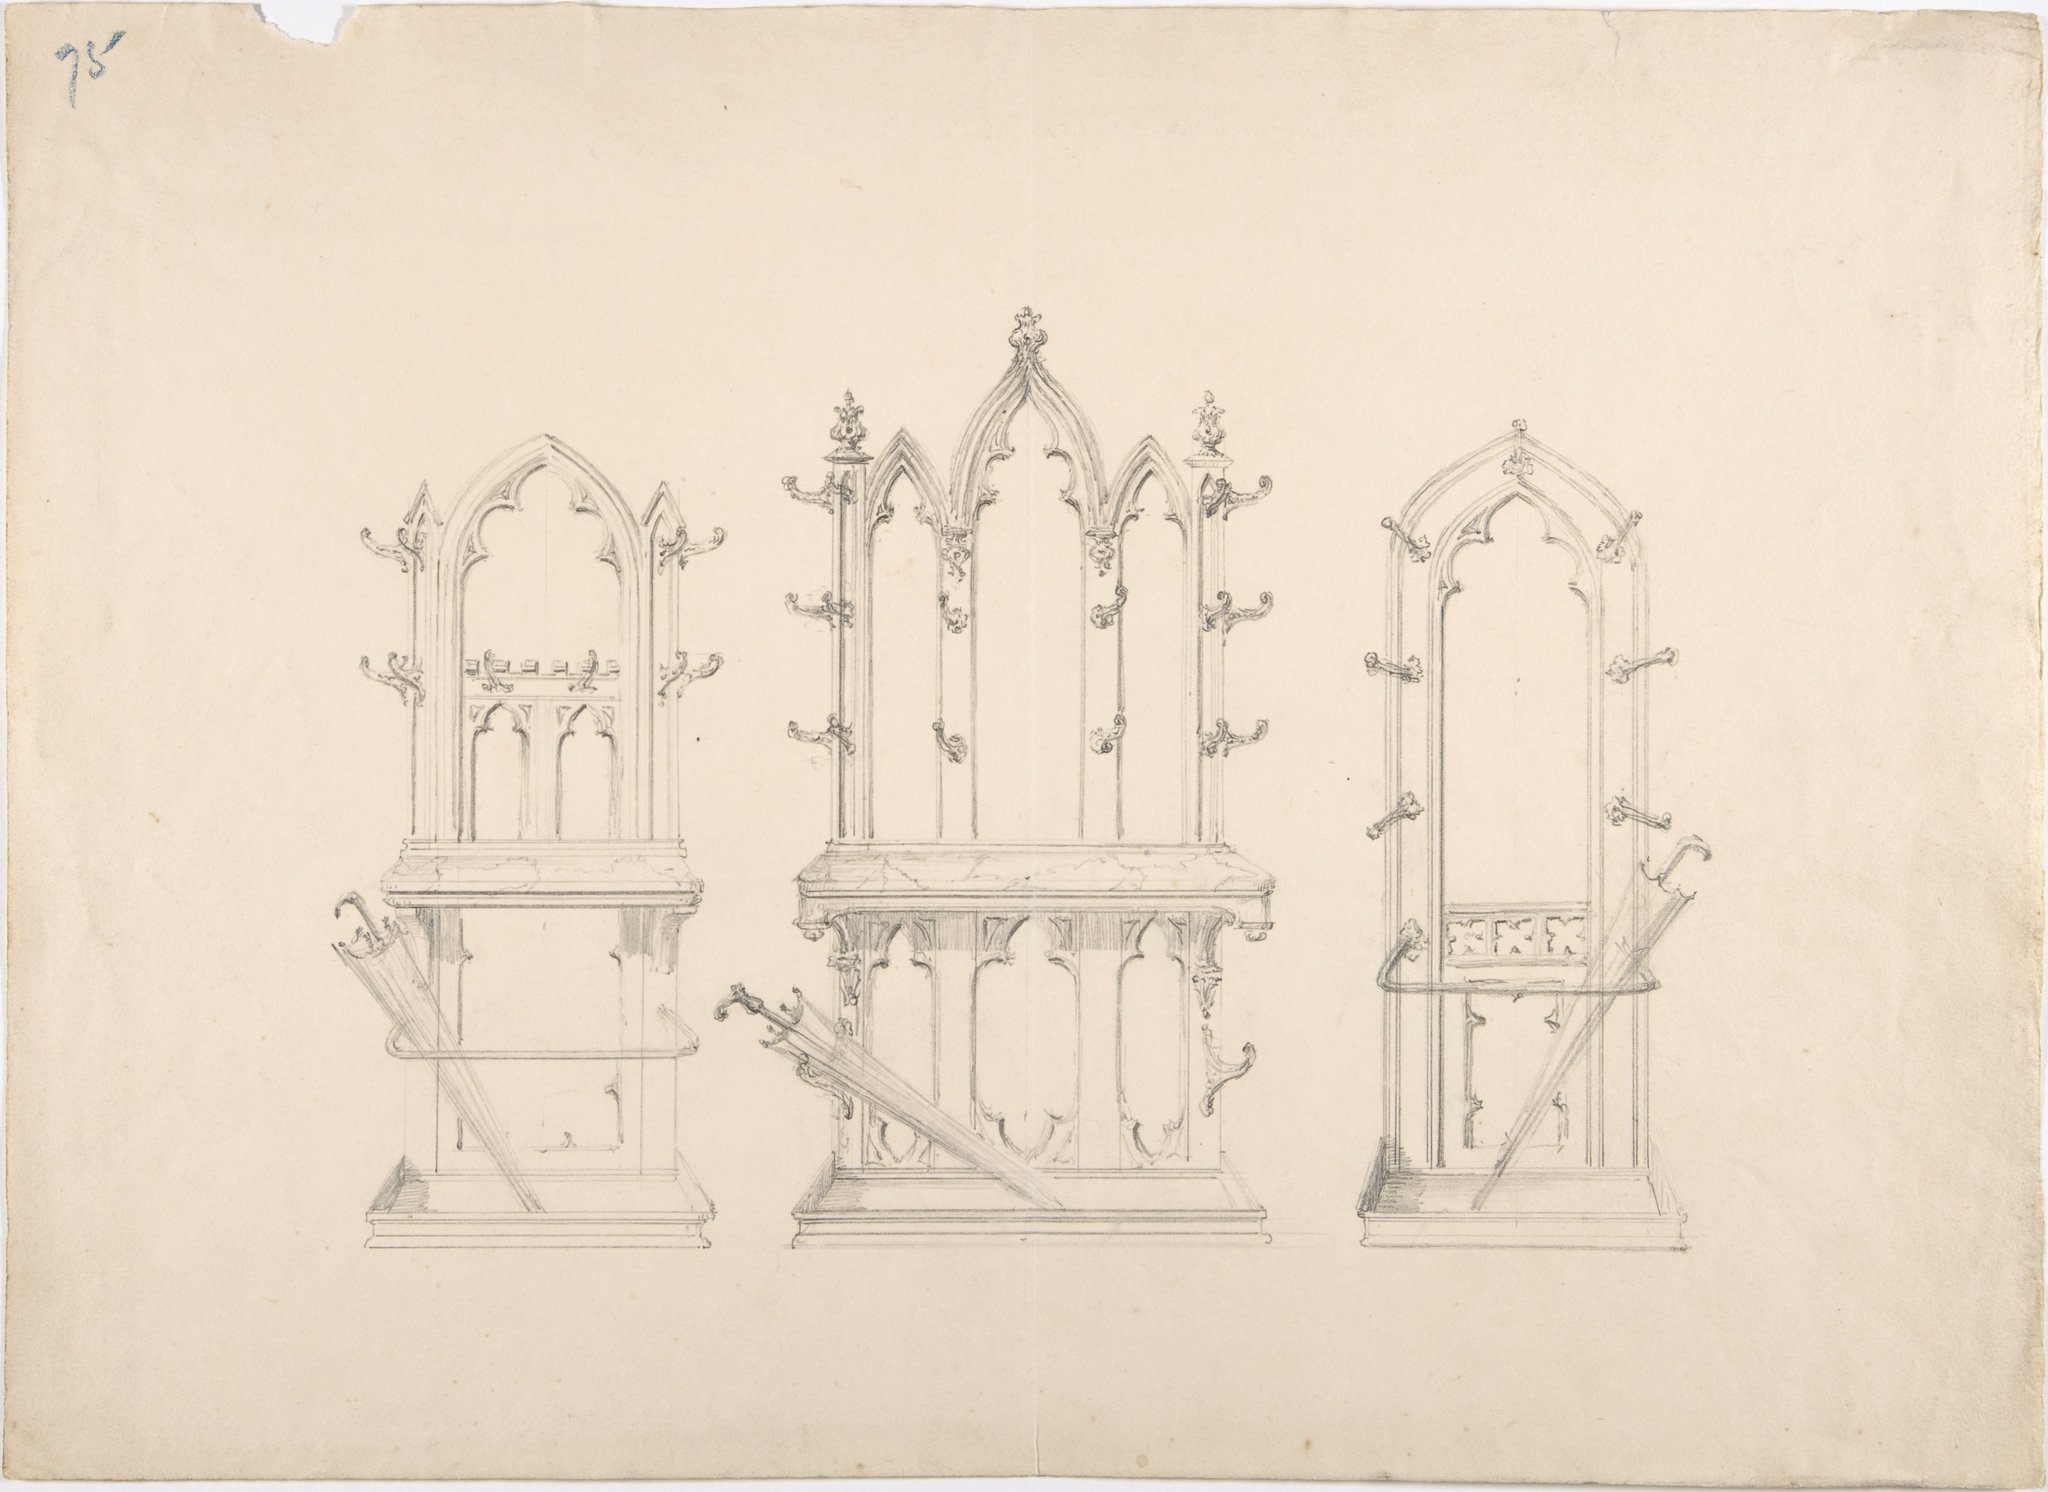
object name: drawing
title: Design for Three Gothic Hat and Umbrella Stands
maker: anonymous, british, 19th century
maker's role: artist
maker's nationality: british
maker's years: 1800-1900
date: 1801-1833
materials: graphite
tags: furniture